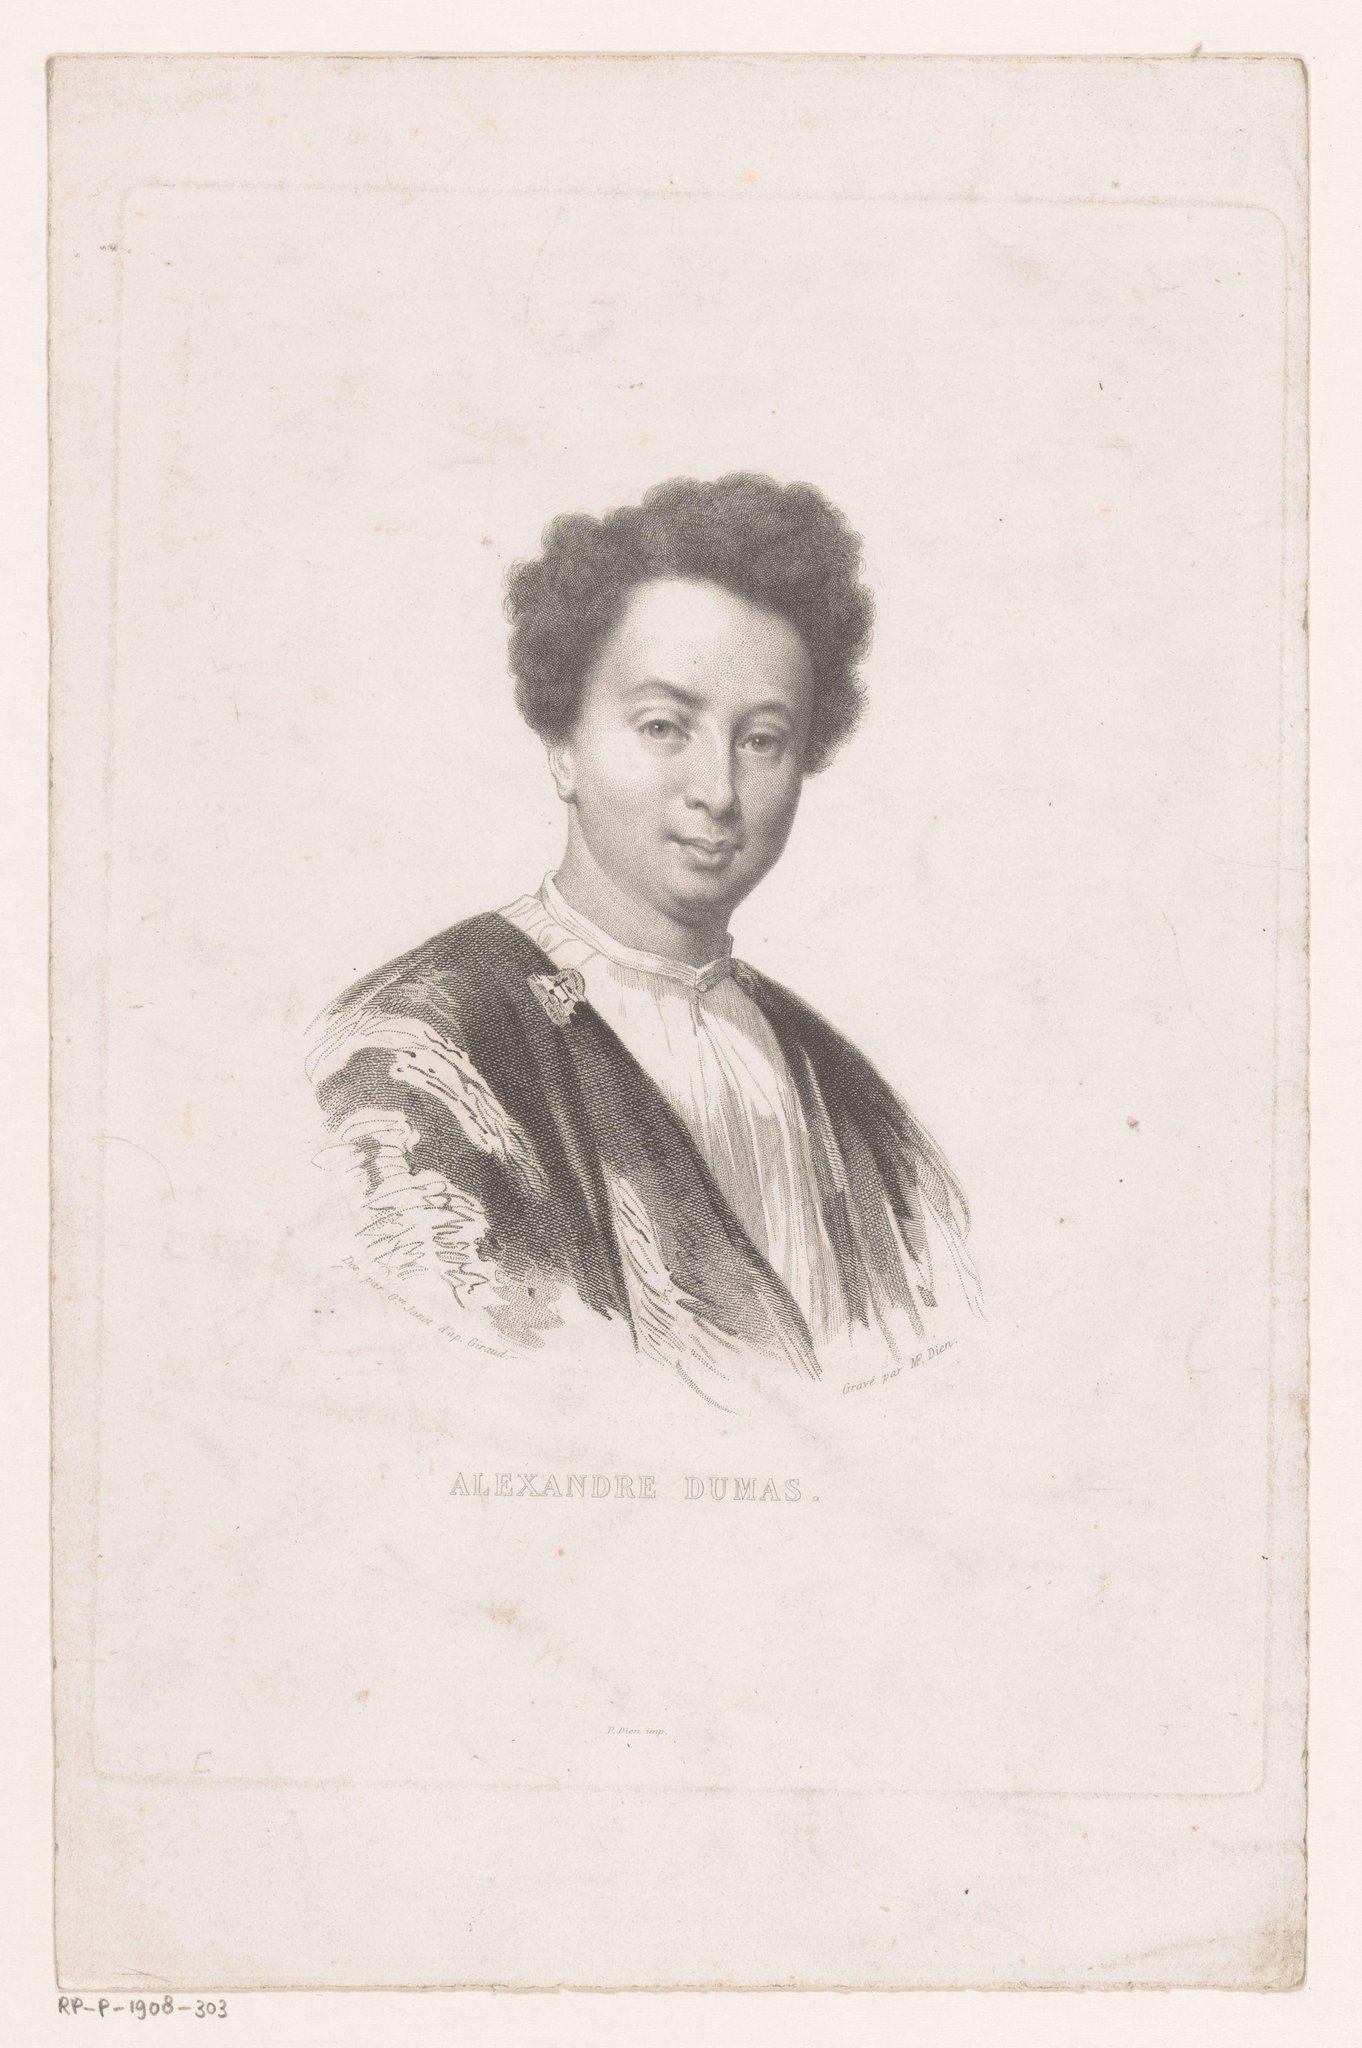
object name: print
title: Portret van Alexandre Dumas père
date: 1839-1865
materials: paper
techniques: engraving, etching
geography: paris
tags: historical persons, portrait of a writer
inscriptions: collector's mark: Lugt 2228